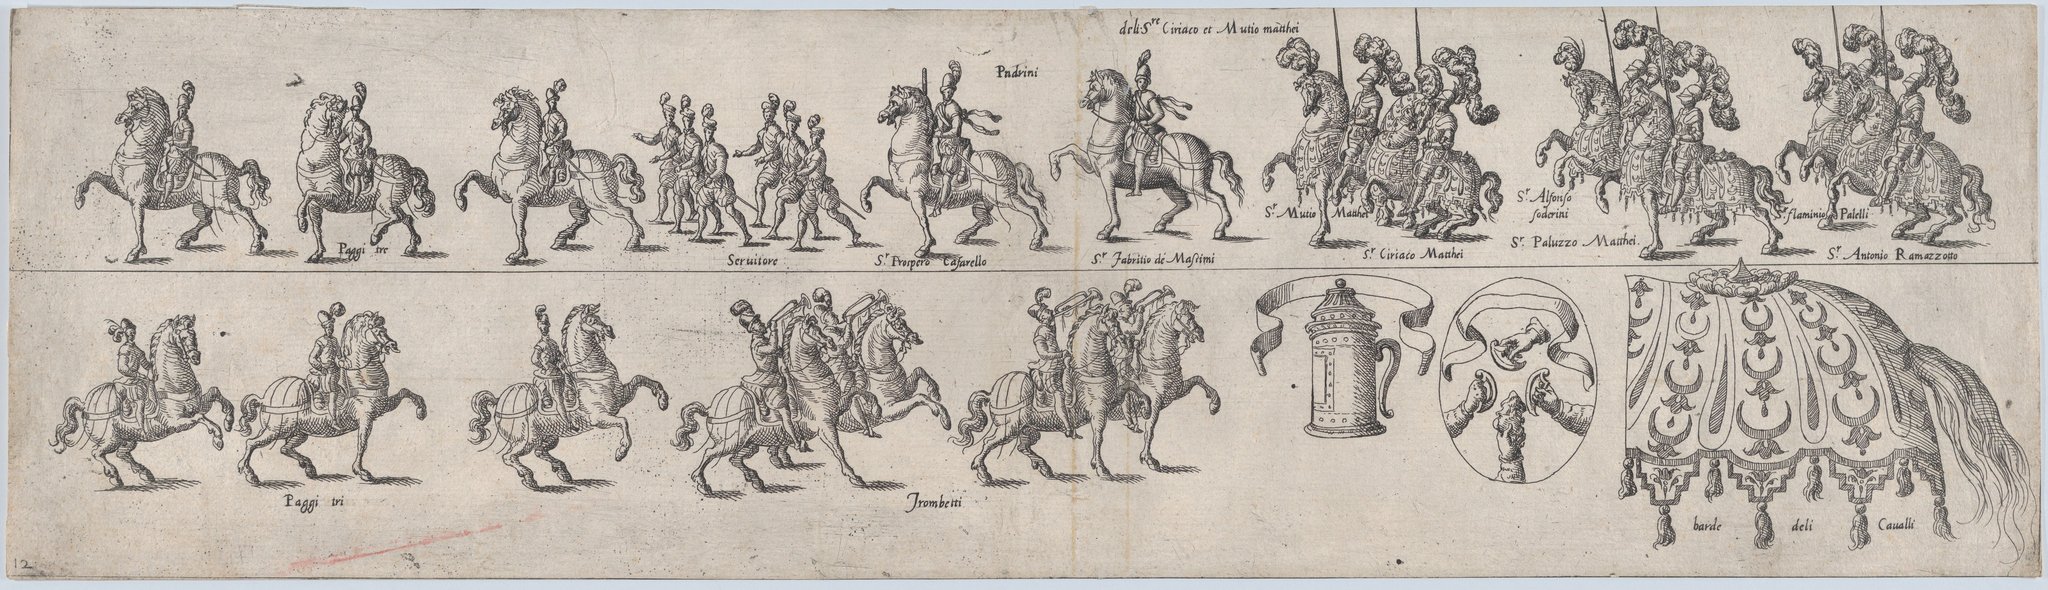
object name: print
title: Plate for Sr. Ciriaco Matthei and Sr. Mutio Matthei, from a series of twelve showing knights and their attendants dressed for a tournament (plate 12)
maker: Anonymous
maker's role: artist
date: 1565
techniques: etching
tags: men,horses,knights